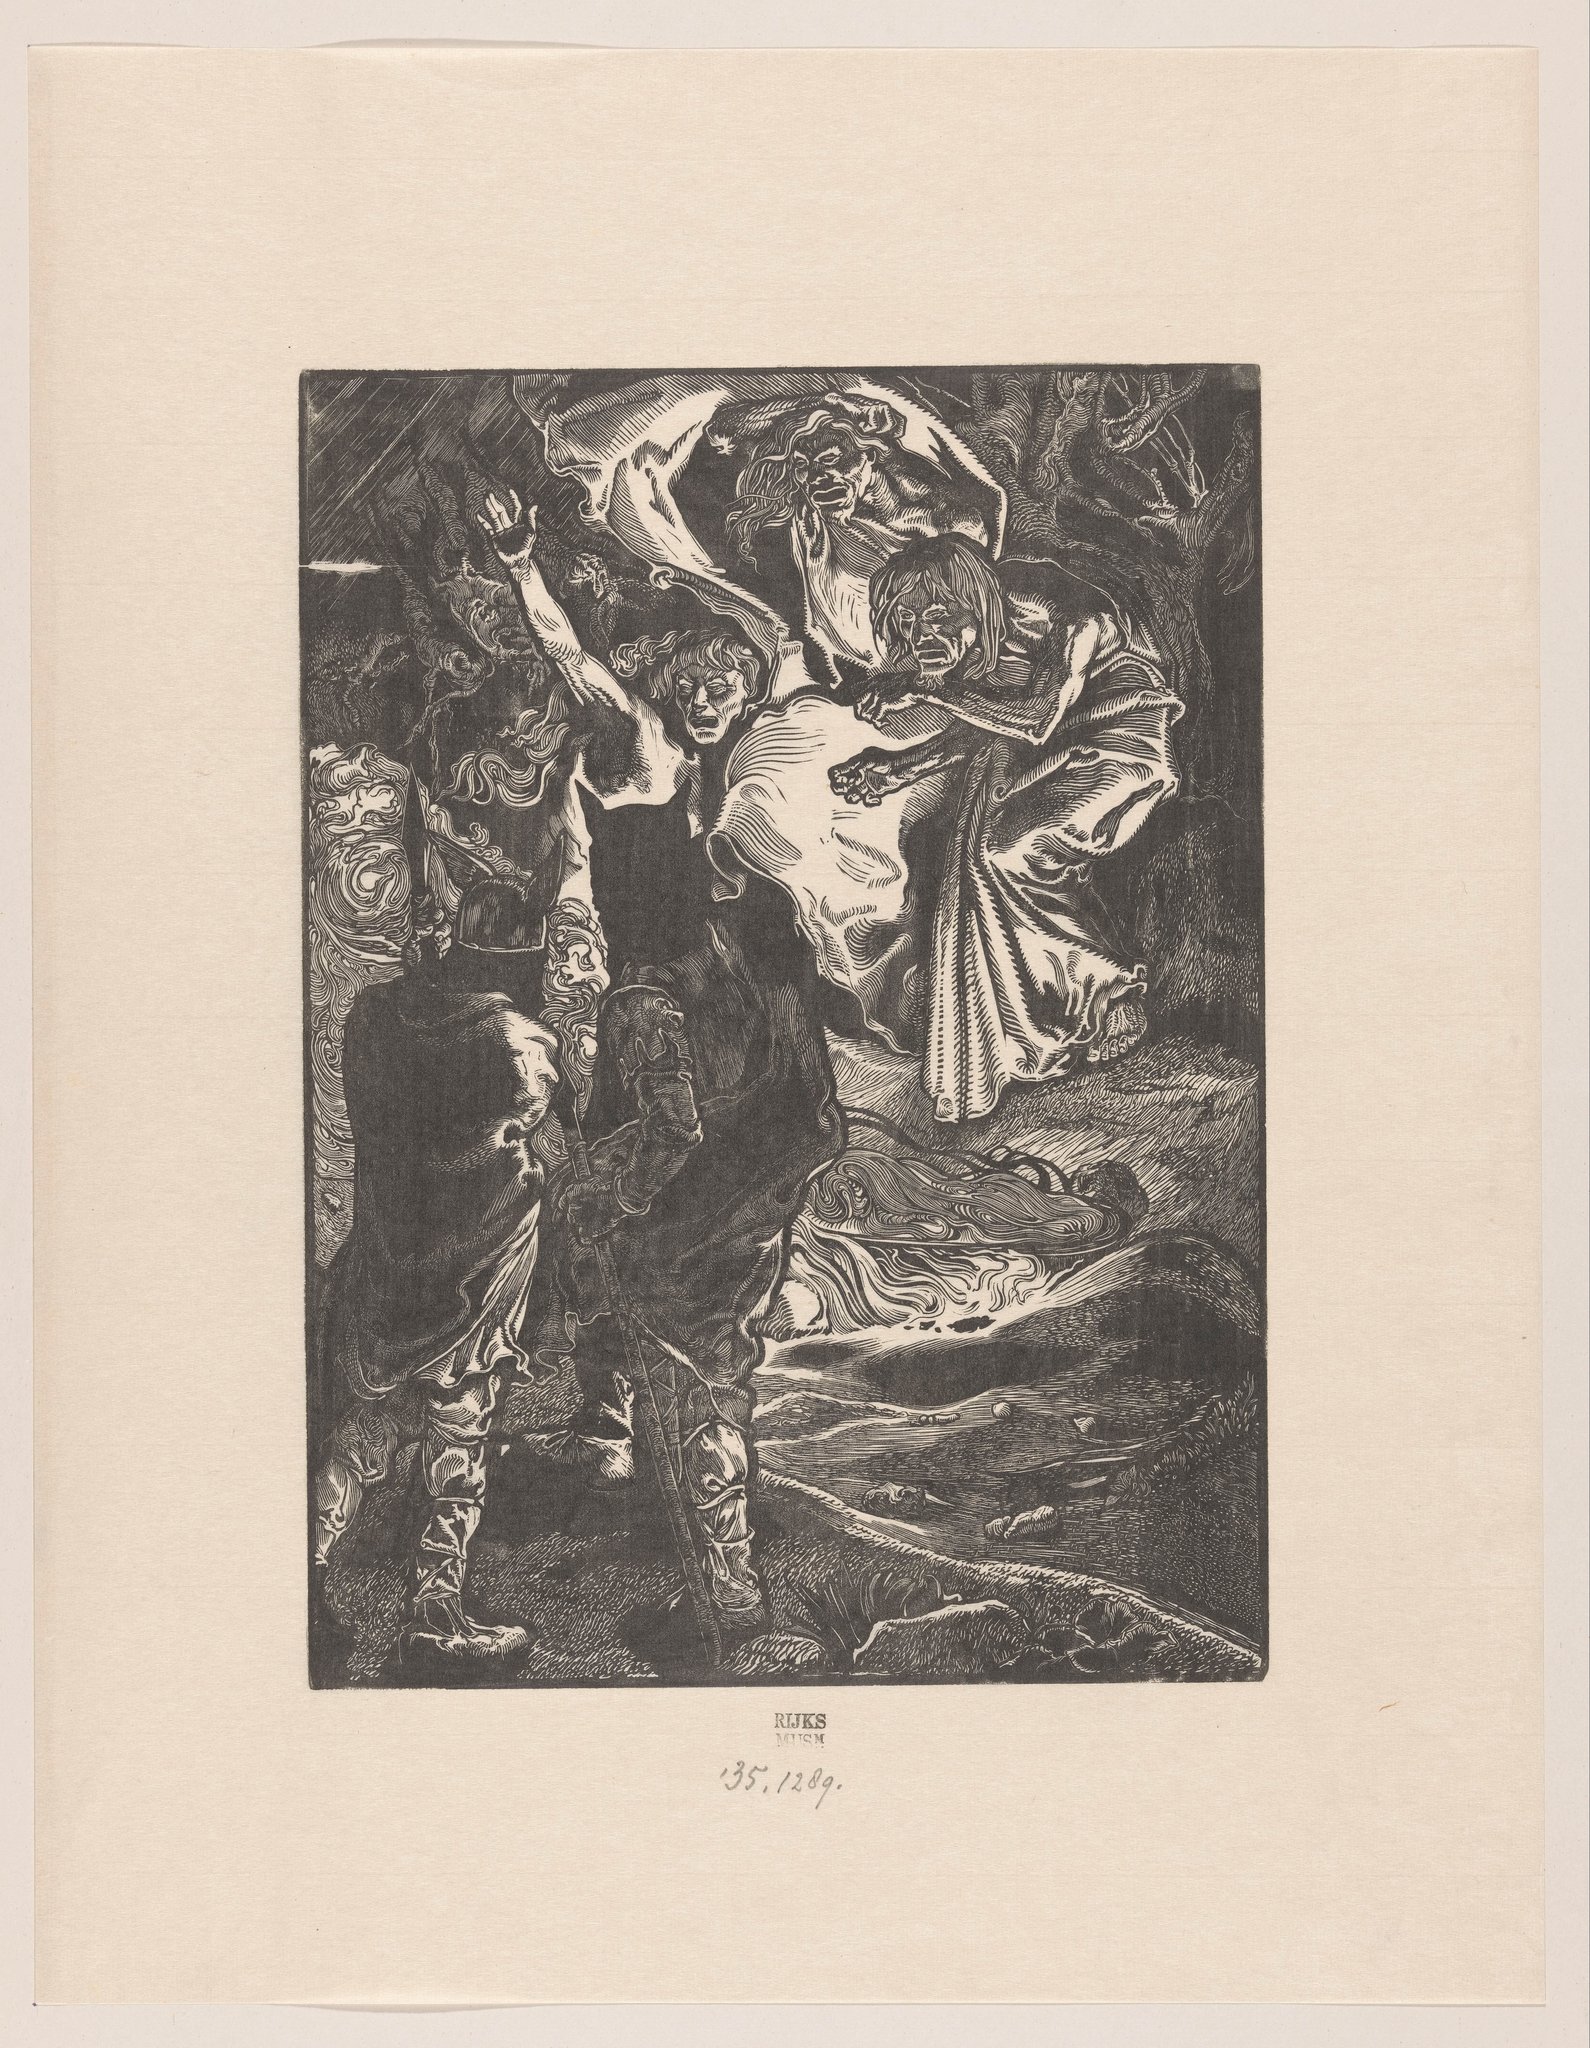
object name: print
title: Macbeth en Banquo ontmoeten de drie heksen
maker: johannes josephus aarts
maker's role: draughtsman, print maker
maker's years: 1871-1934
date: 1881-1934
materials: paper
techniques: woodcut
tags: groups of witches, macbeth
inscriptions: collector's mark: Lugt 2166, collector's mark: Lugt 2166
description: Linksonder Macbeth en zijn vriend Banquo, rechtsboven de drie heksen die voor elk van hen voorspellingen in petto hebben.